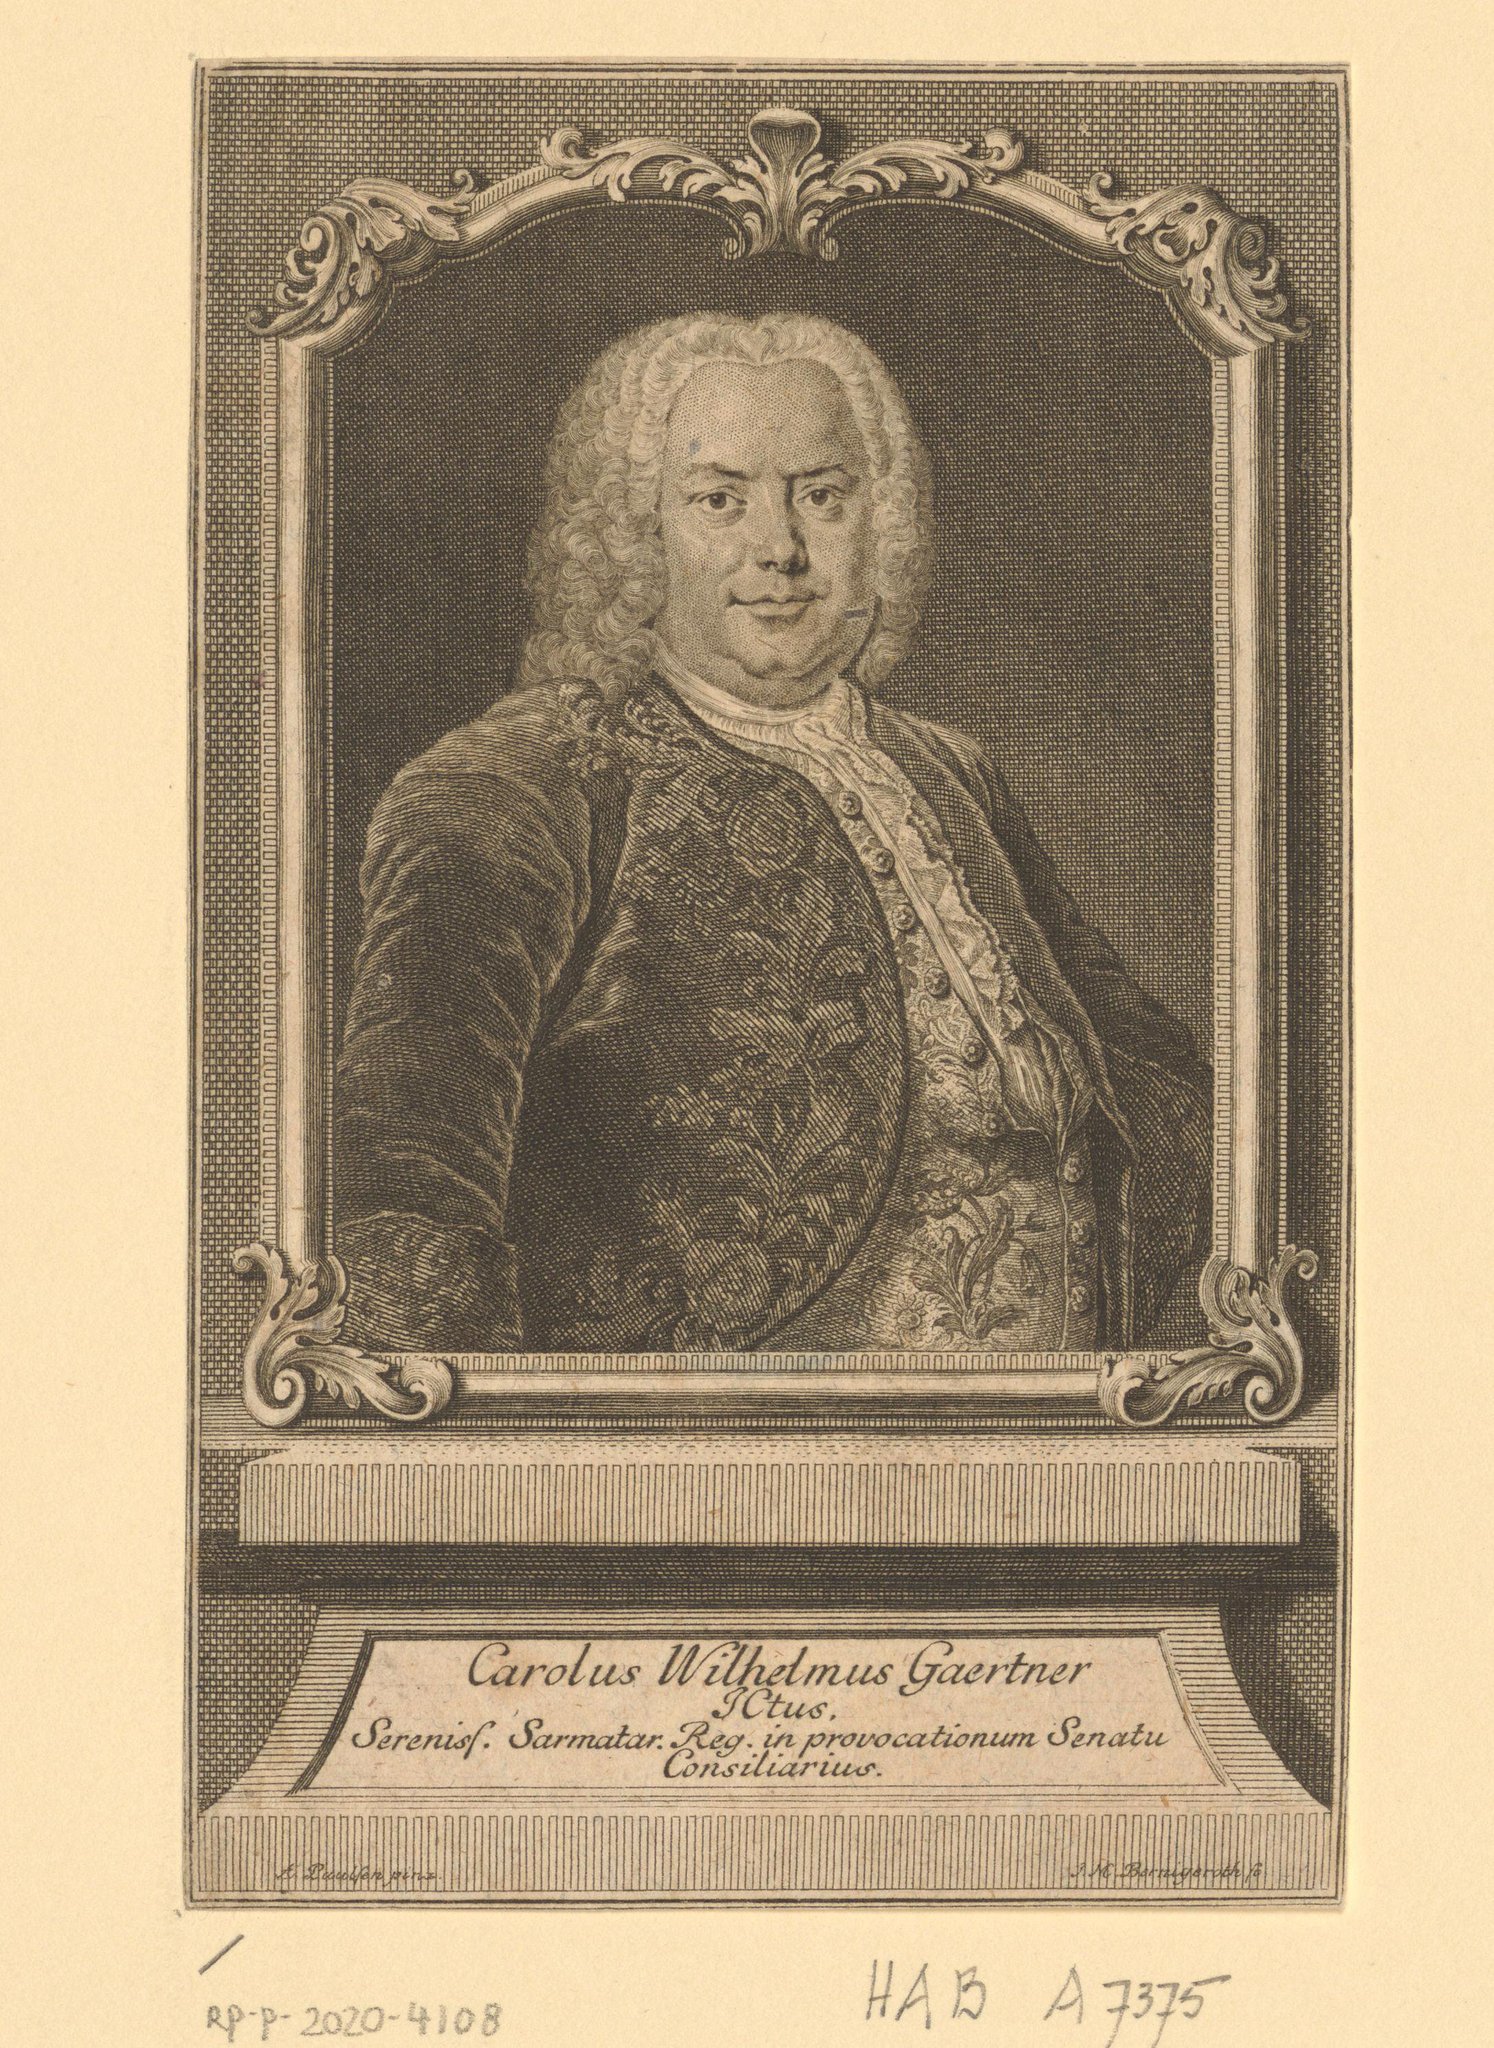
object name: book illustration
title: Portret van Carl Wilhelm Gaertner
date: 1740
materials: paper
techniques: engraving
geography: leipzig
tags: vienna, scholar, philosopher, historical persons, lawyer, attorney at law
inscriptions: collector's mark: Lugt 2228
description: Prent uit: Zuverläßige Nachrichten von dem gegenwärtigen Zustande, Veränderung und Wachsthum der Wissenschaften. Leipzig: Johann Friedrich Gleditsch, 1740.